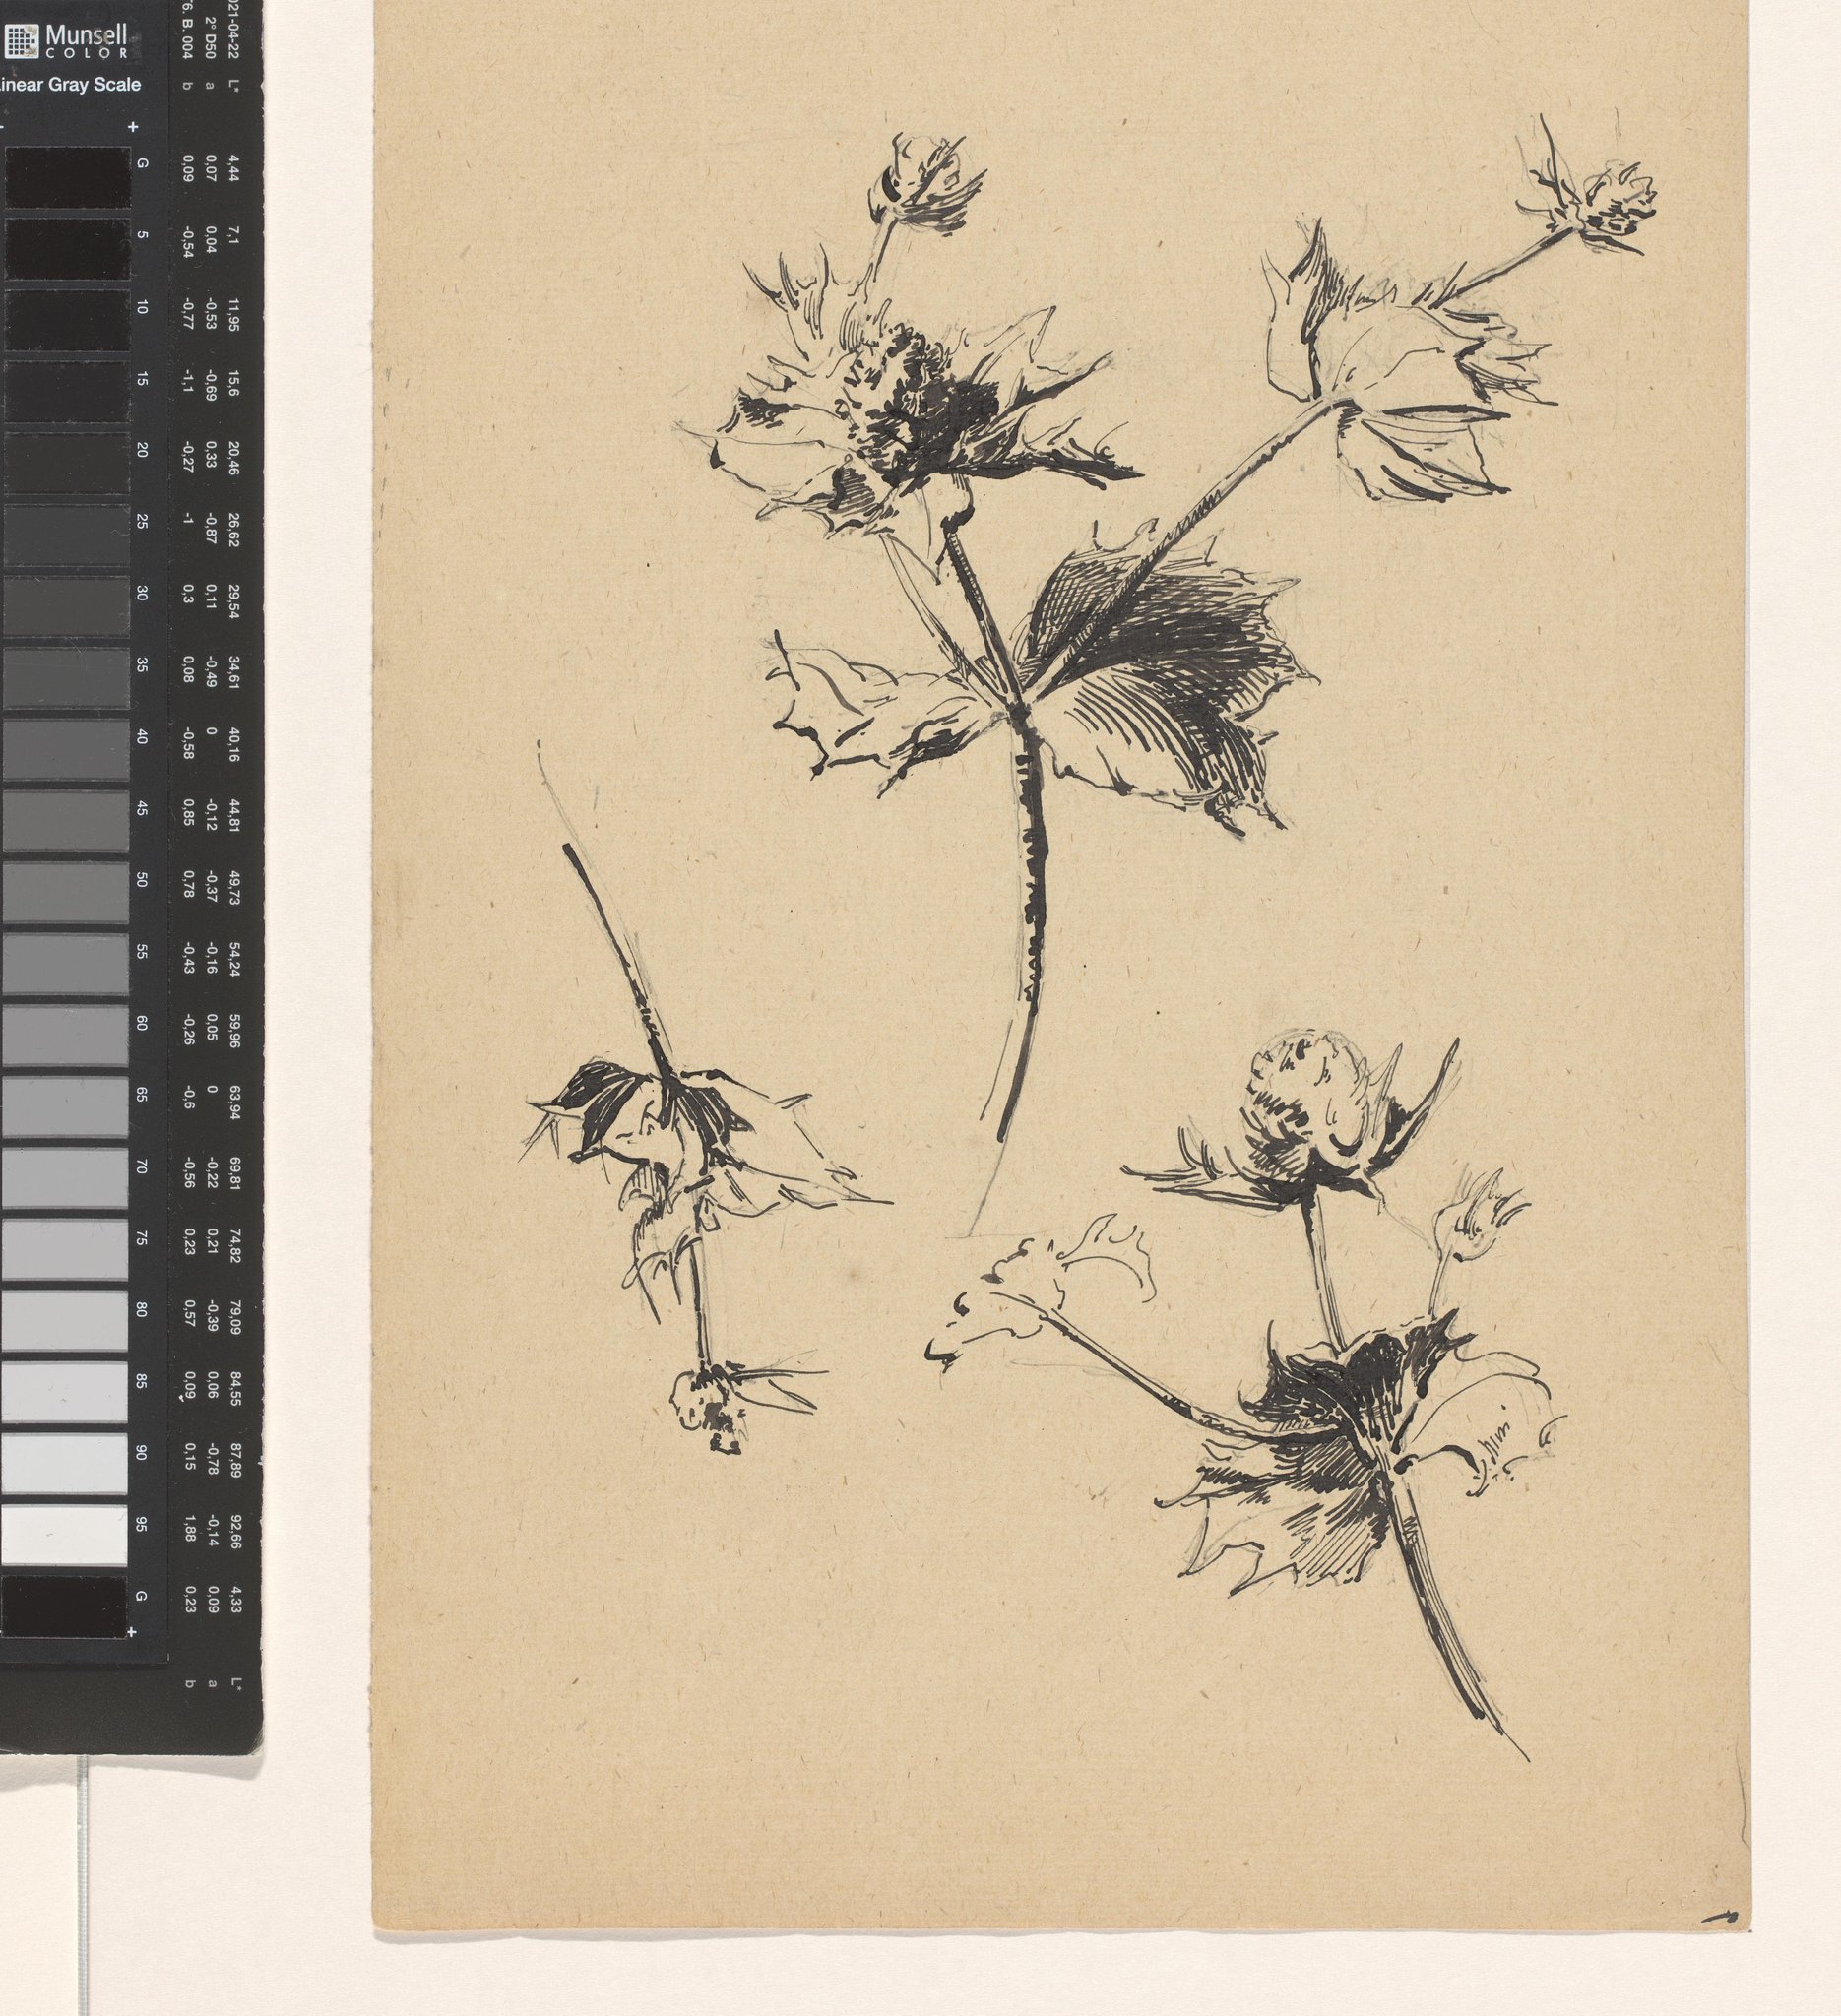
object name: schetsblad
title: Takjes met bloemen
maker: johanna behrend-croiset van der kop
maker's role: draughtsman, painter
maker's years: 1861-1943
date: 1880-1900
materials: ink, paper, pencil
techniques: pen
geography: netherlands